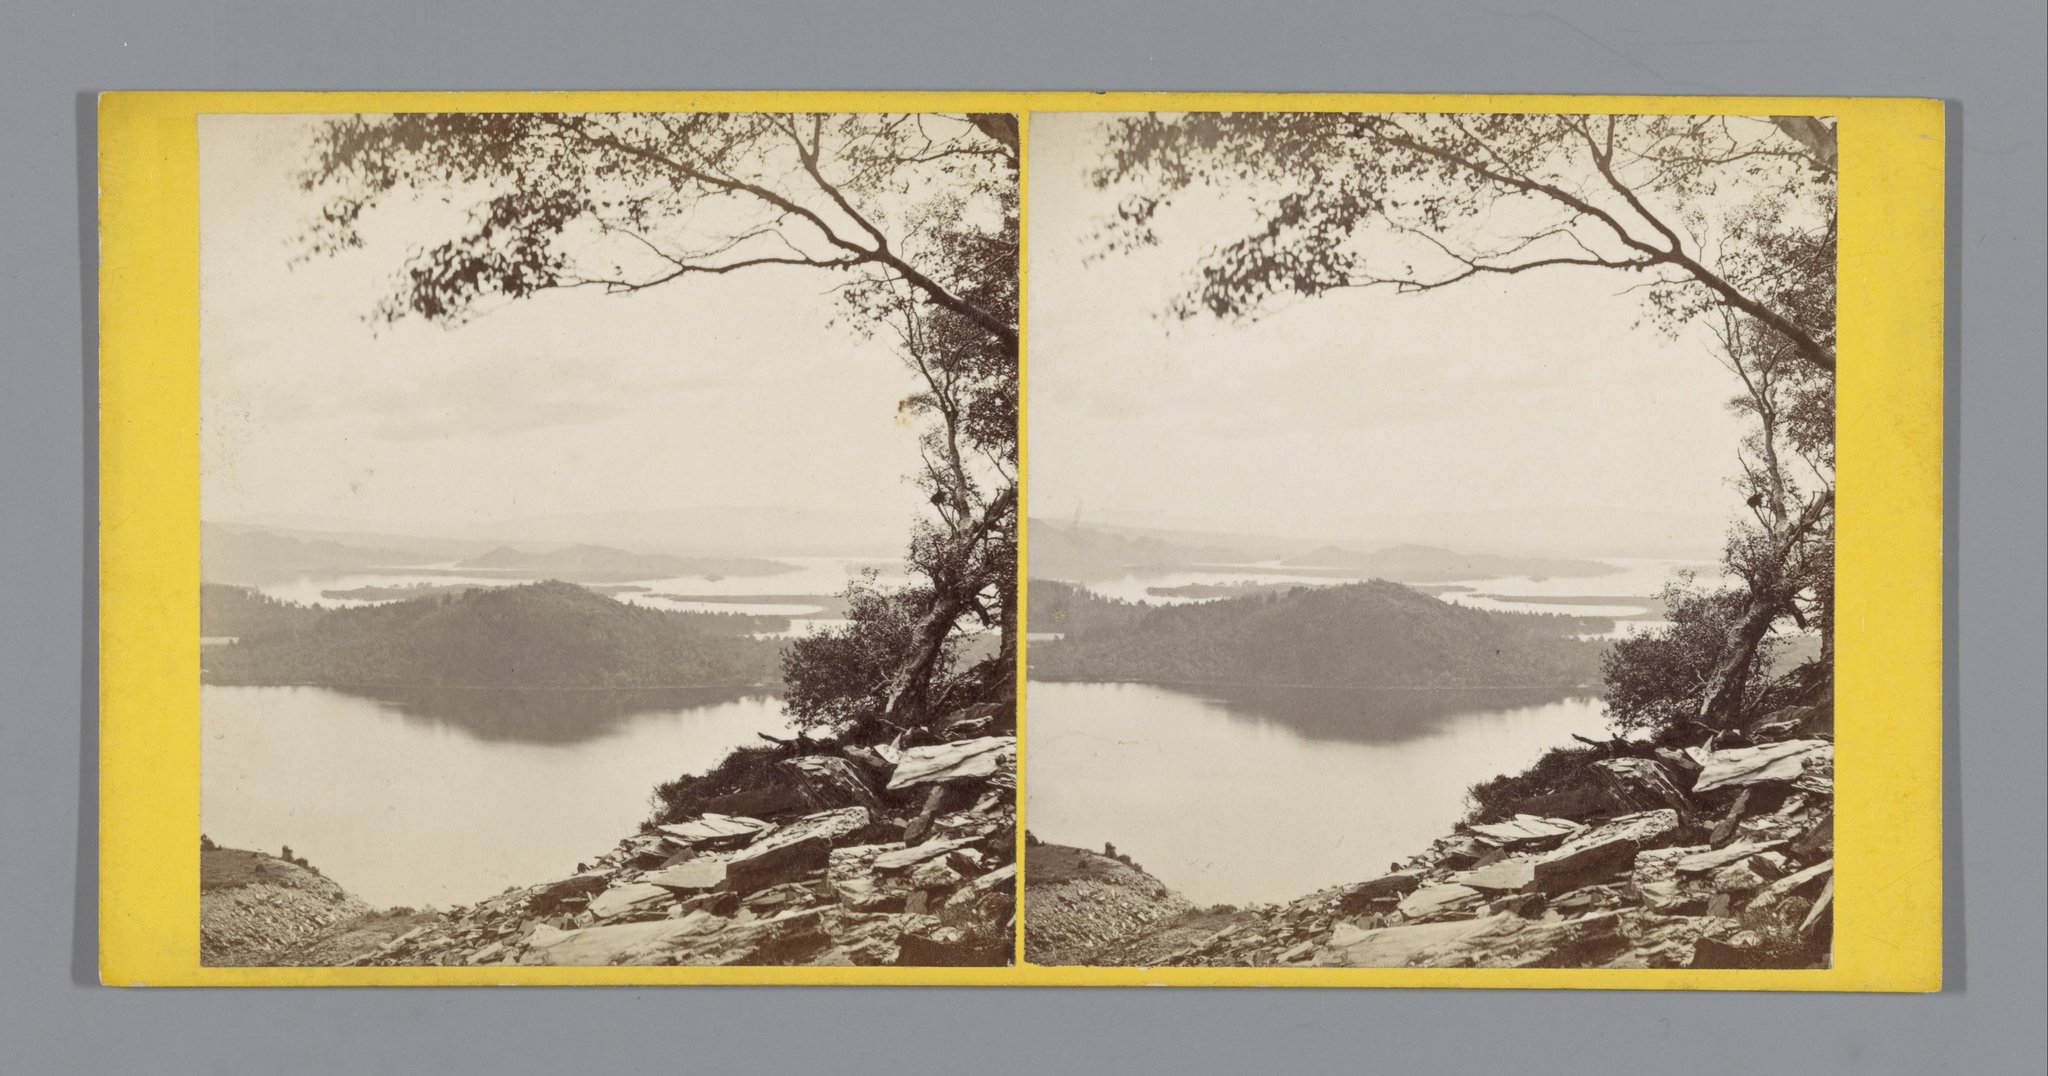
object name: stereograph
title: Loch Lomond-from Luss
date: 1858-1872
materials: cardboard, photographic support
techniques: albumen print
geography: loch lomond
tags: lake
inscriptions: number: ‘No. 830A.’